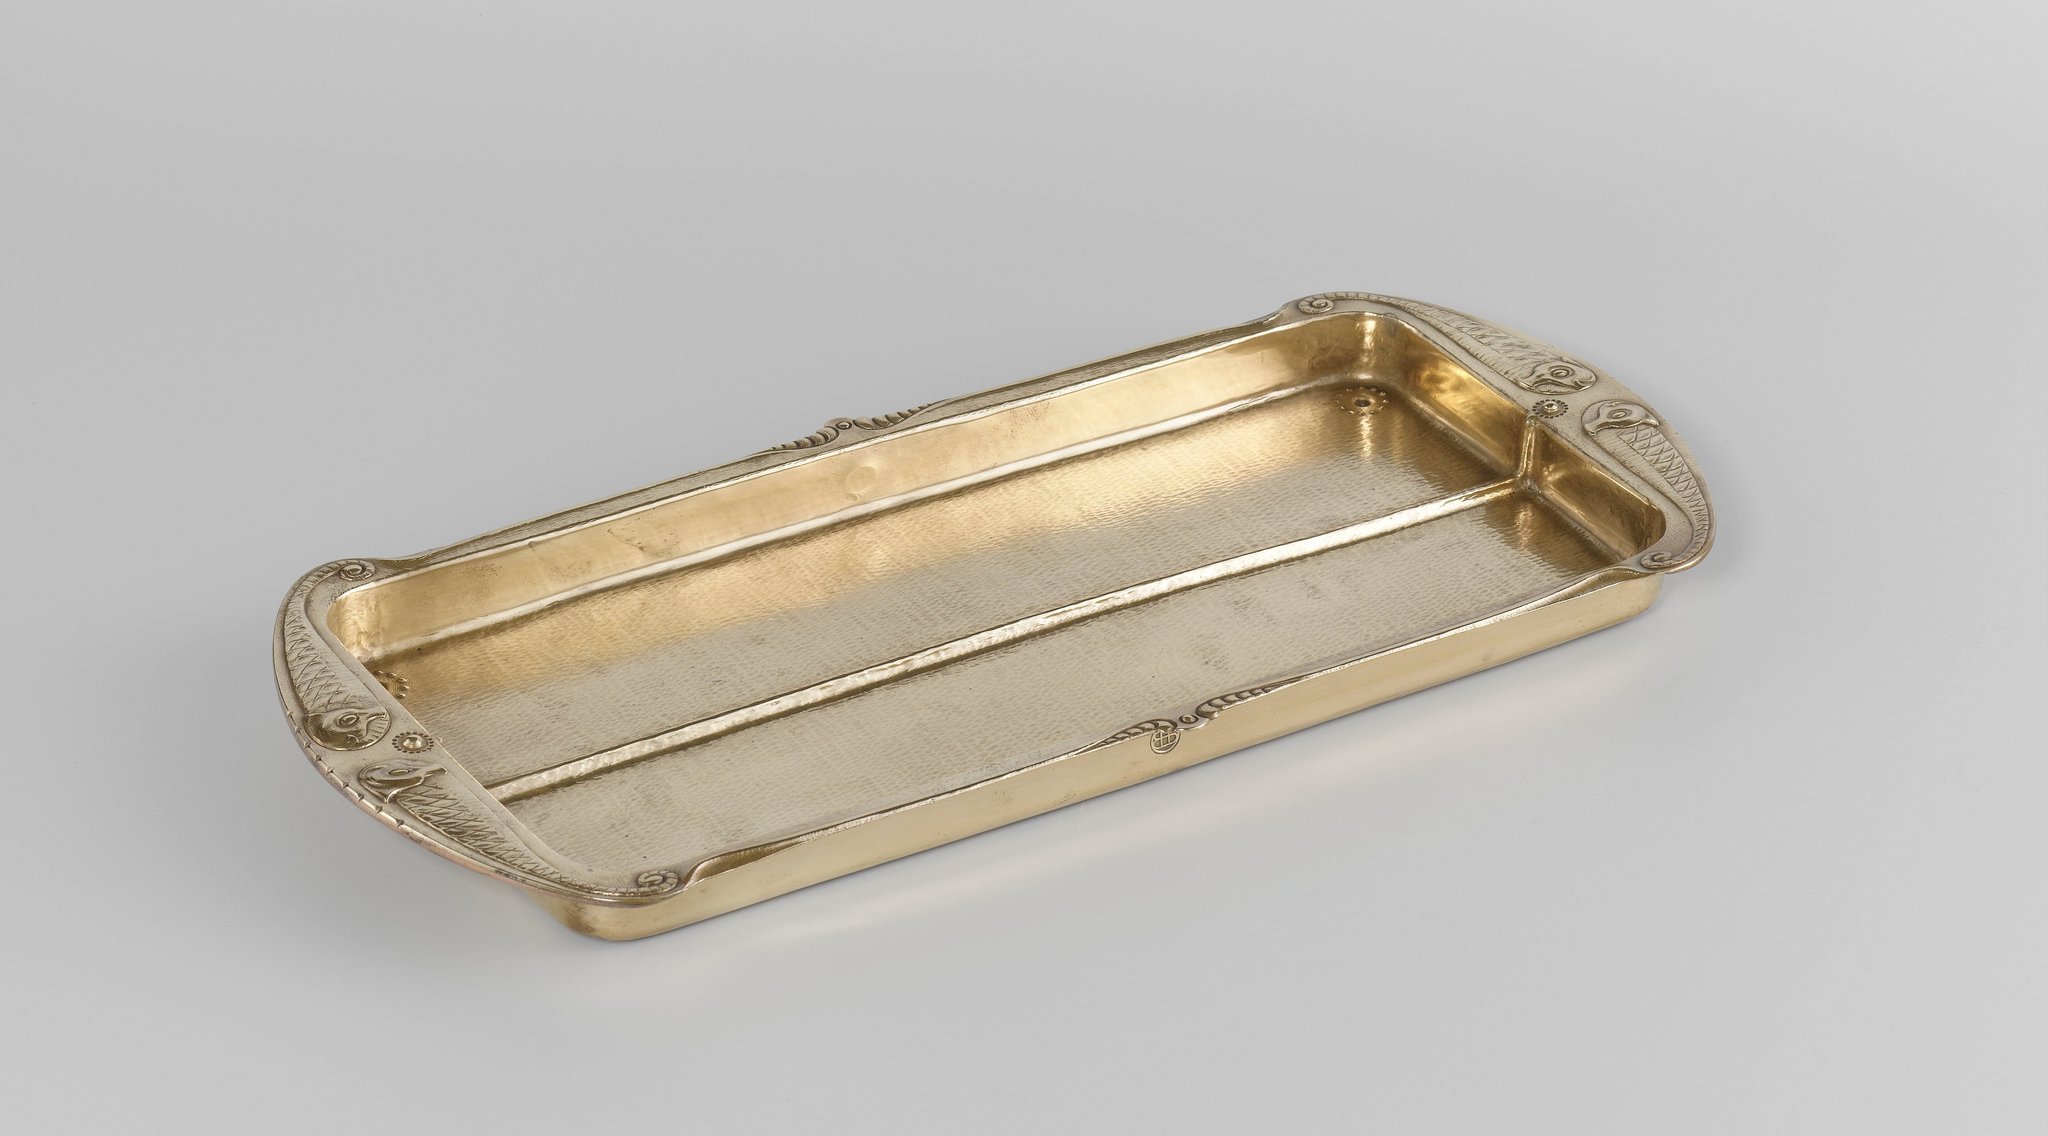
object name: pen tray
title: Pennenbak versierd met rozetten en zeepaardjes.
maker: jacob pieter van den bosch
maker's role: draughtsman, print maker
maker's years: 1868-1948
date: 1900-1910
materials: copper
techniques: hammering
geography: amsterdam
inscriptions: workshop stamp, maker's mark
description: De gedreven bak van koper heeft een rechthoekige vorm met een lage wand, die overgaat in een uitstekende rand. Hij is door een in de lengte over het midden lopende verhoogde rib in twee vakken verdeeld voor pennen en ander schrijfgerei. De bodem is overdwars met hamerslagen decoratief bewerkt. In de hoeken zijn vier rozetten geslagen, zodanig dat de harten aan de onderkant bolvormig zijn en tot pootjes van het voorwerp dienen. Dit motief is tegengesteld herhaald aan de einden van de rib, op de verbrede korte randen. Ter weerszijden daarvan zijn twee gestileerde antithetisch geplaatste zeepaardjes gedreven. De middens van de lange smalle randen zijn met enig gedreven ornament geaccentueerd.